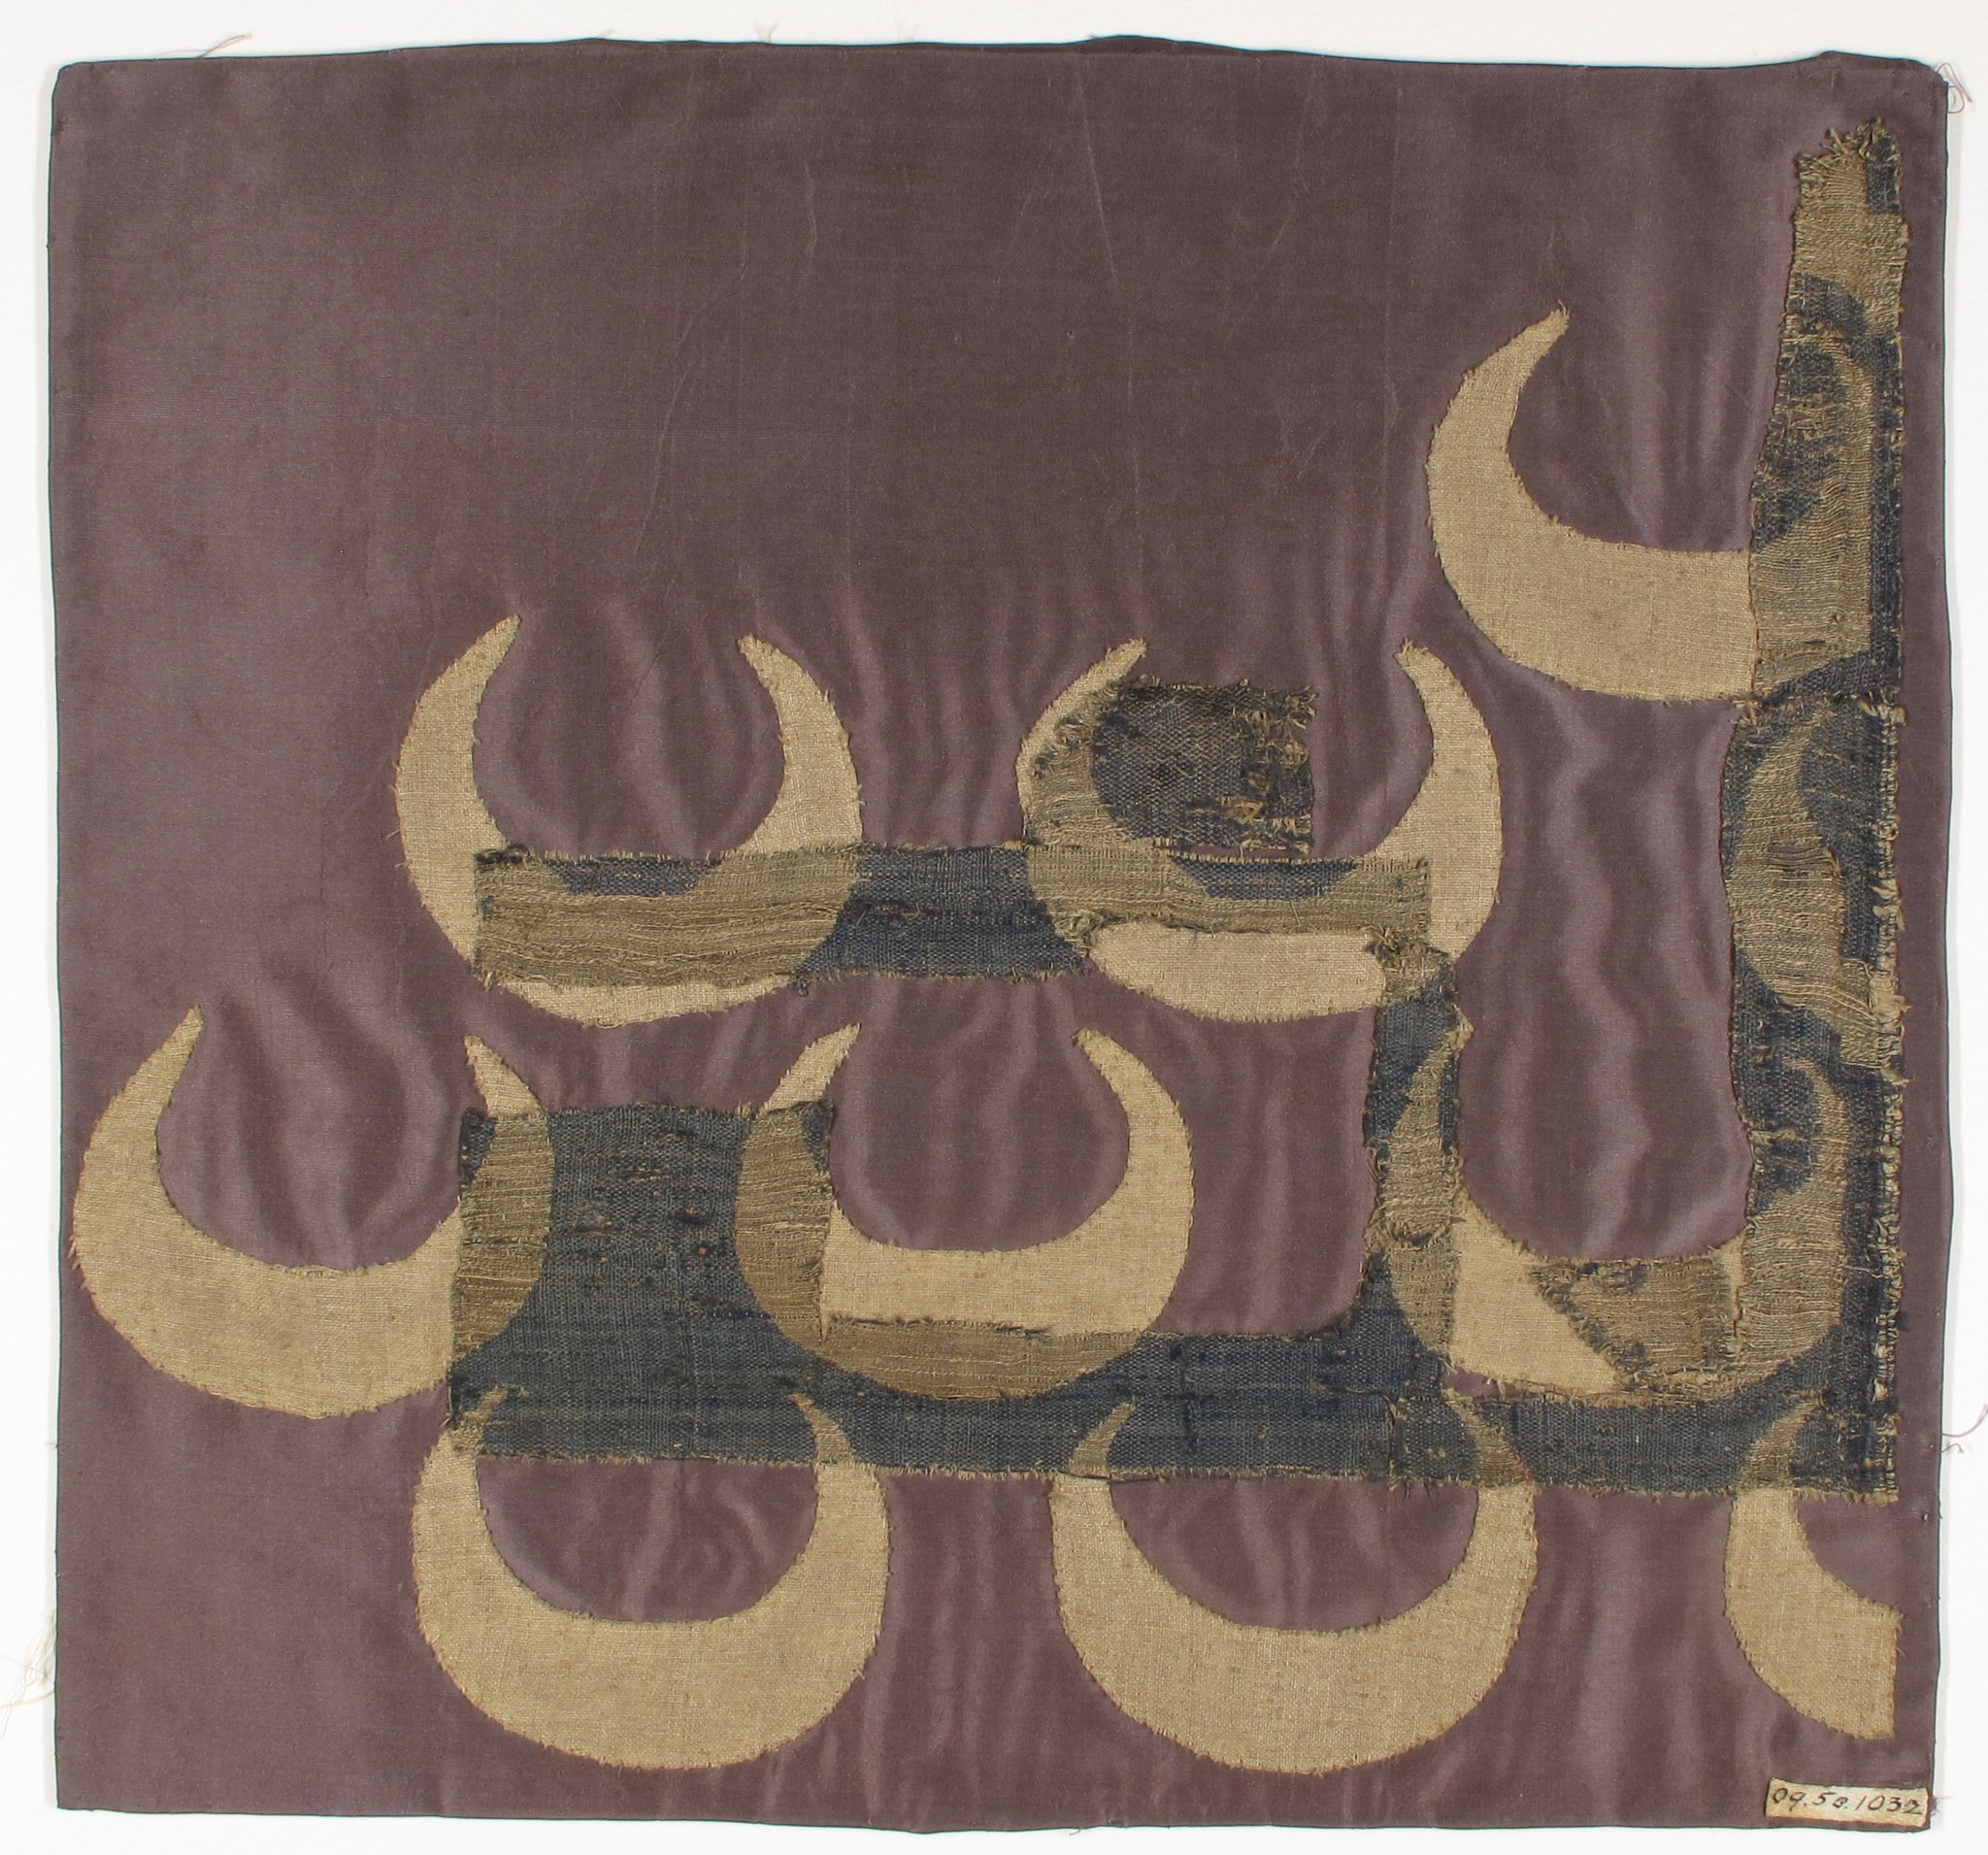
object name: textile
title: Textile with Crescents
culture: italian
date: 901-1200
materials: metal thread, silk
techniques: brocade